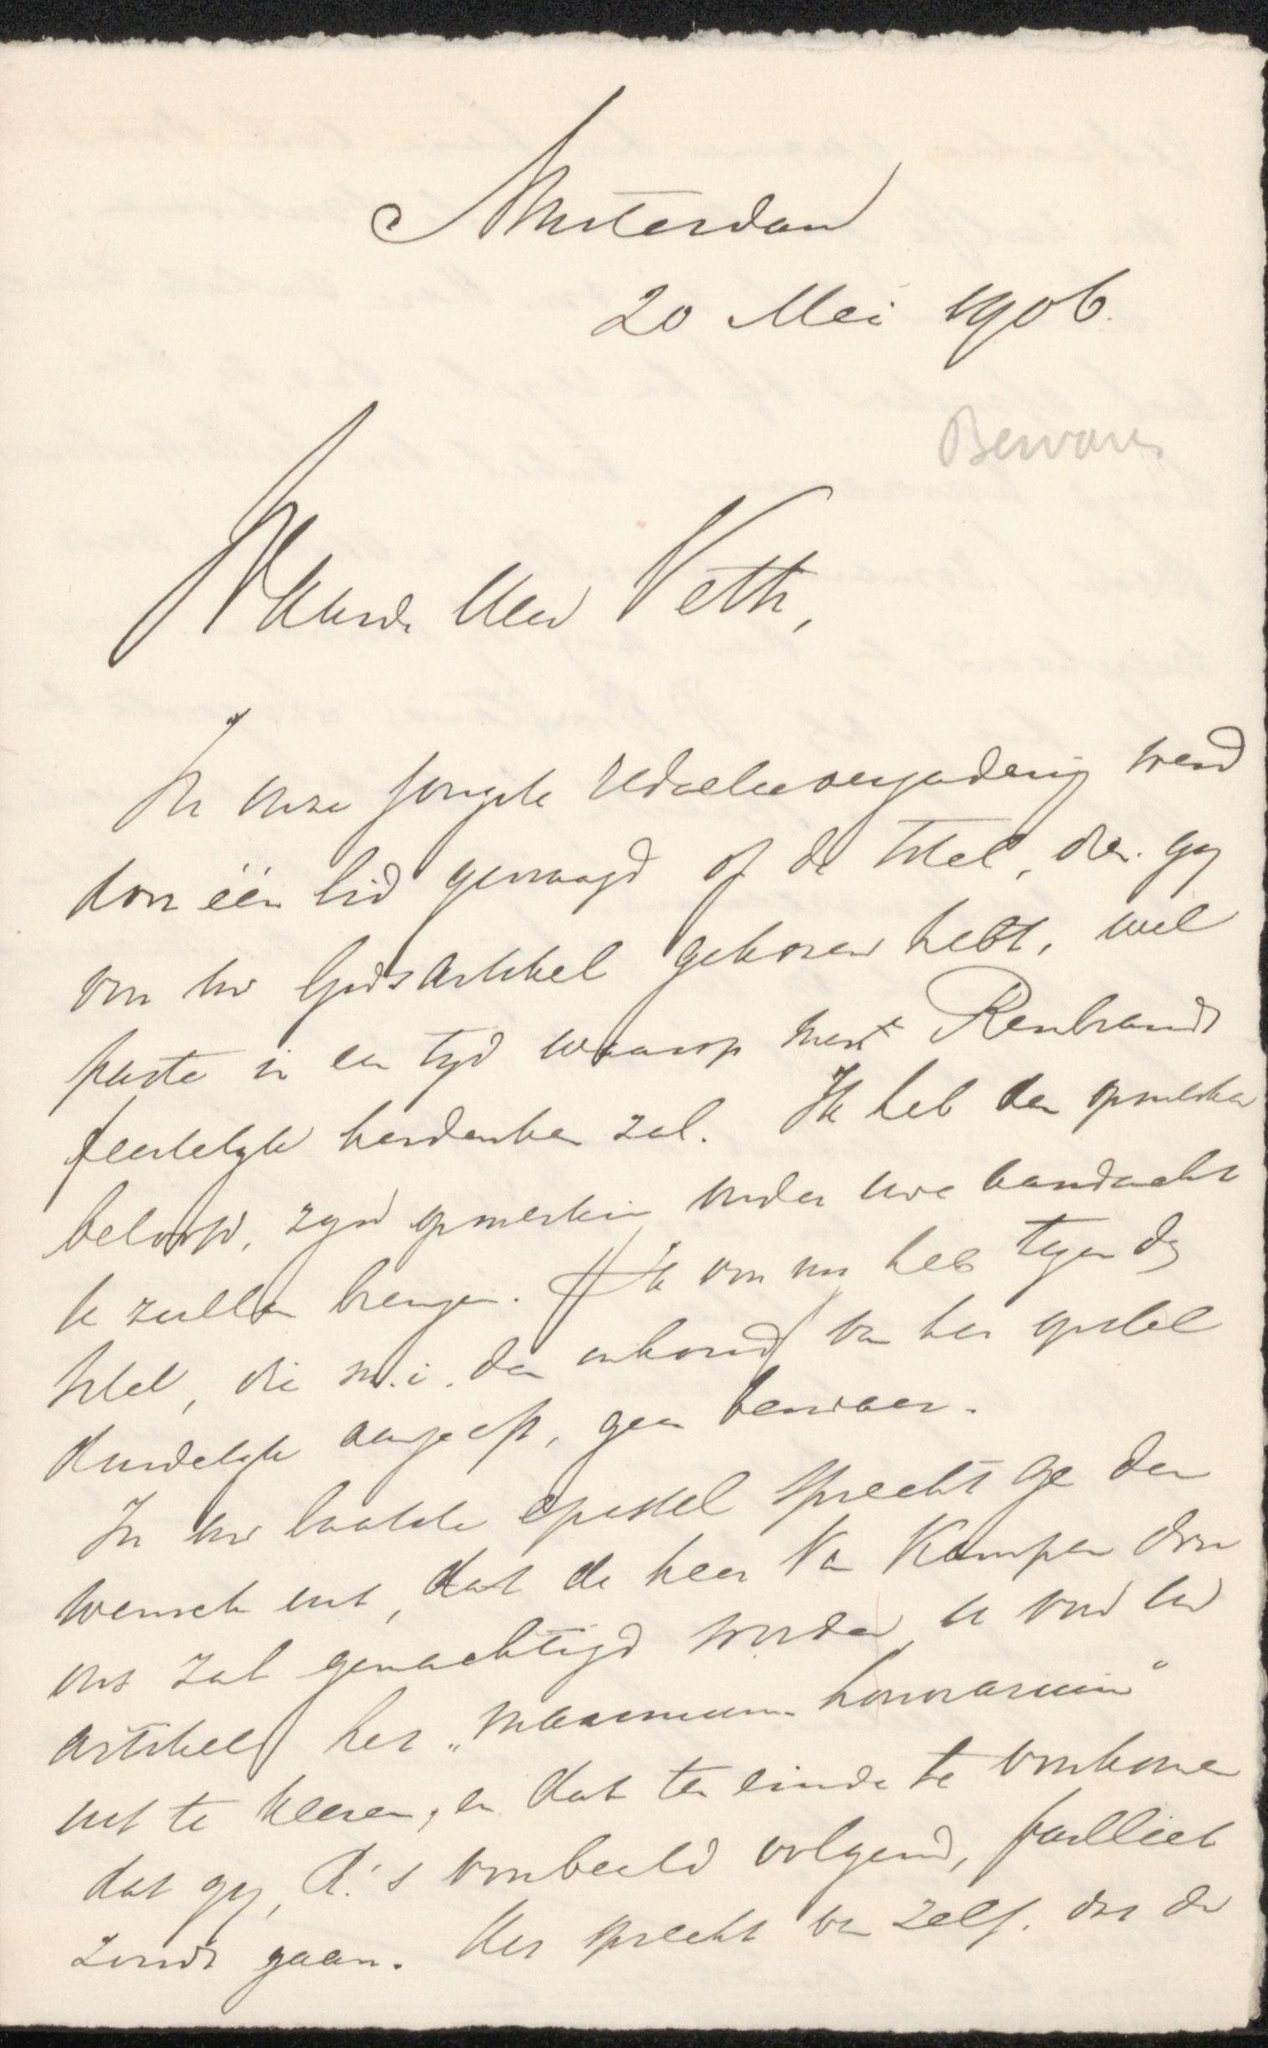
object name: letter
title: Brief aan Jan Veth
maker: jacob nicolaas van hall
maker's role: politician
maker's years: 1840-1918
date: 1906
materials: ink, paper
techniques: pen, writing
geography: amsterdam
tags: designer, jan veth, leiden, painter, draughtsman, rembrandt van rijn, money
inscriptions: watermark, collector's mark: ‘RPK’